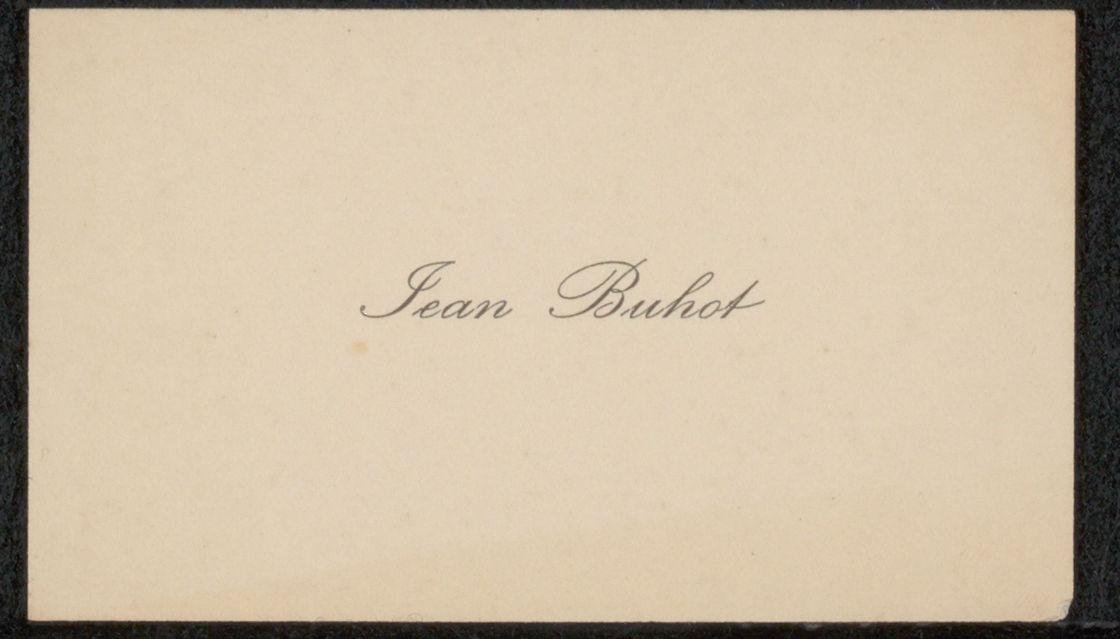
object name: visiting card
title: Visitekaartje aan Philip Zilcken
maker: jean buhot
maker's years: 1885-1952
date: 1895-1952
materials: cardboard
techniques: printing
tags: paris, jean buhot, painter, draughtsman, philip zilcken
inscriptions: collector's mark: ‘RPK’